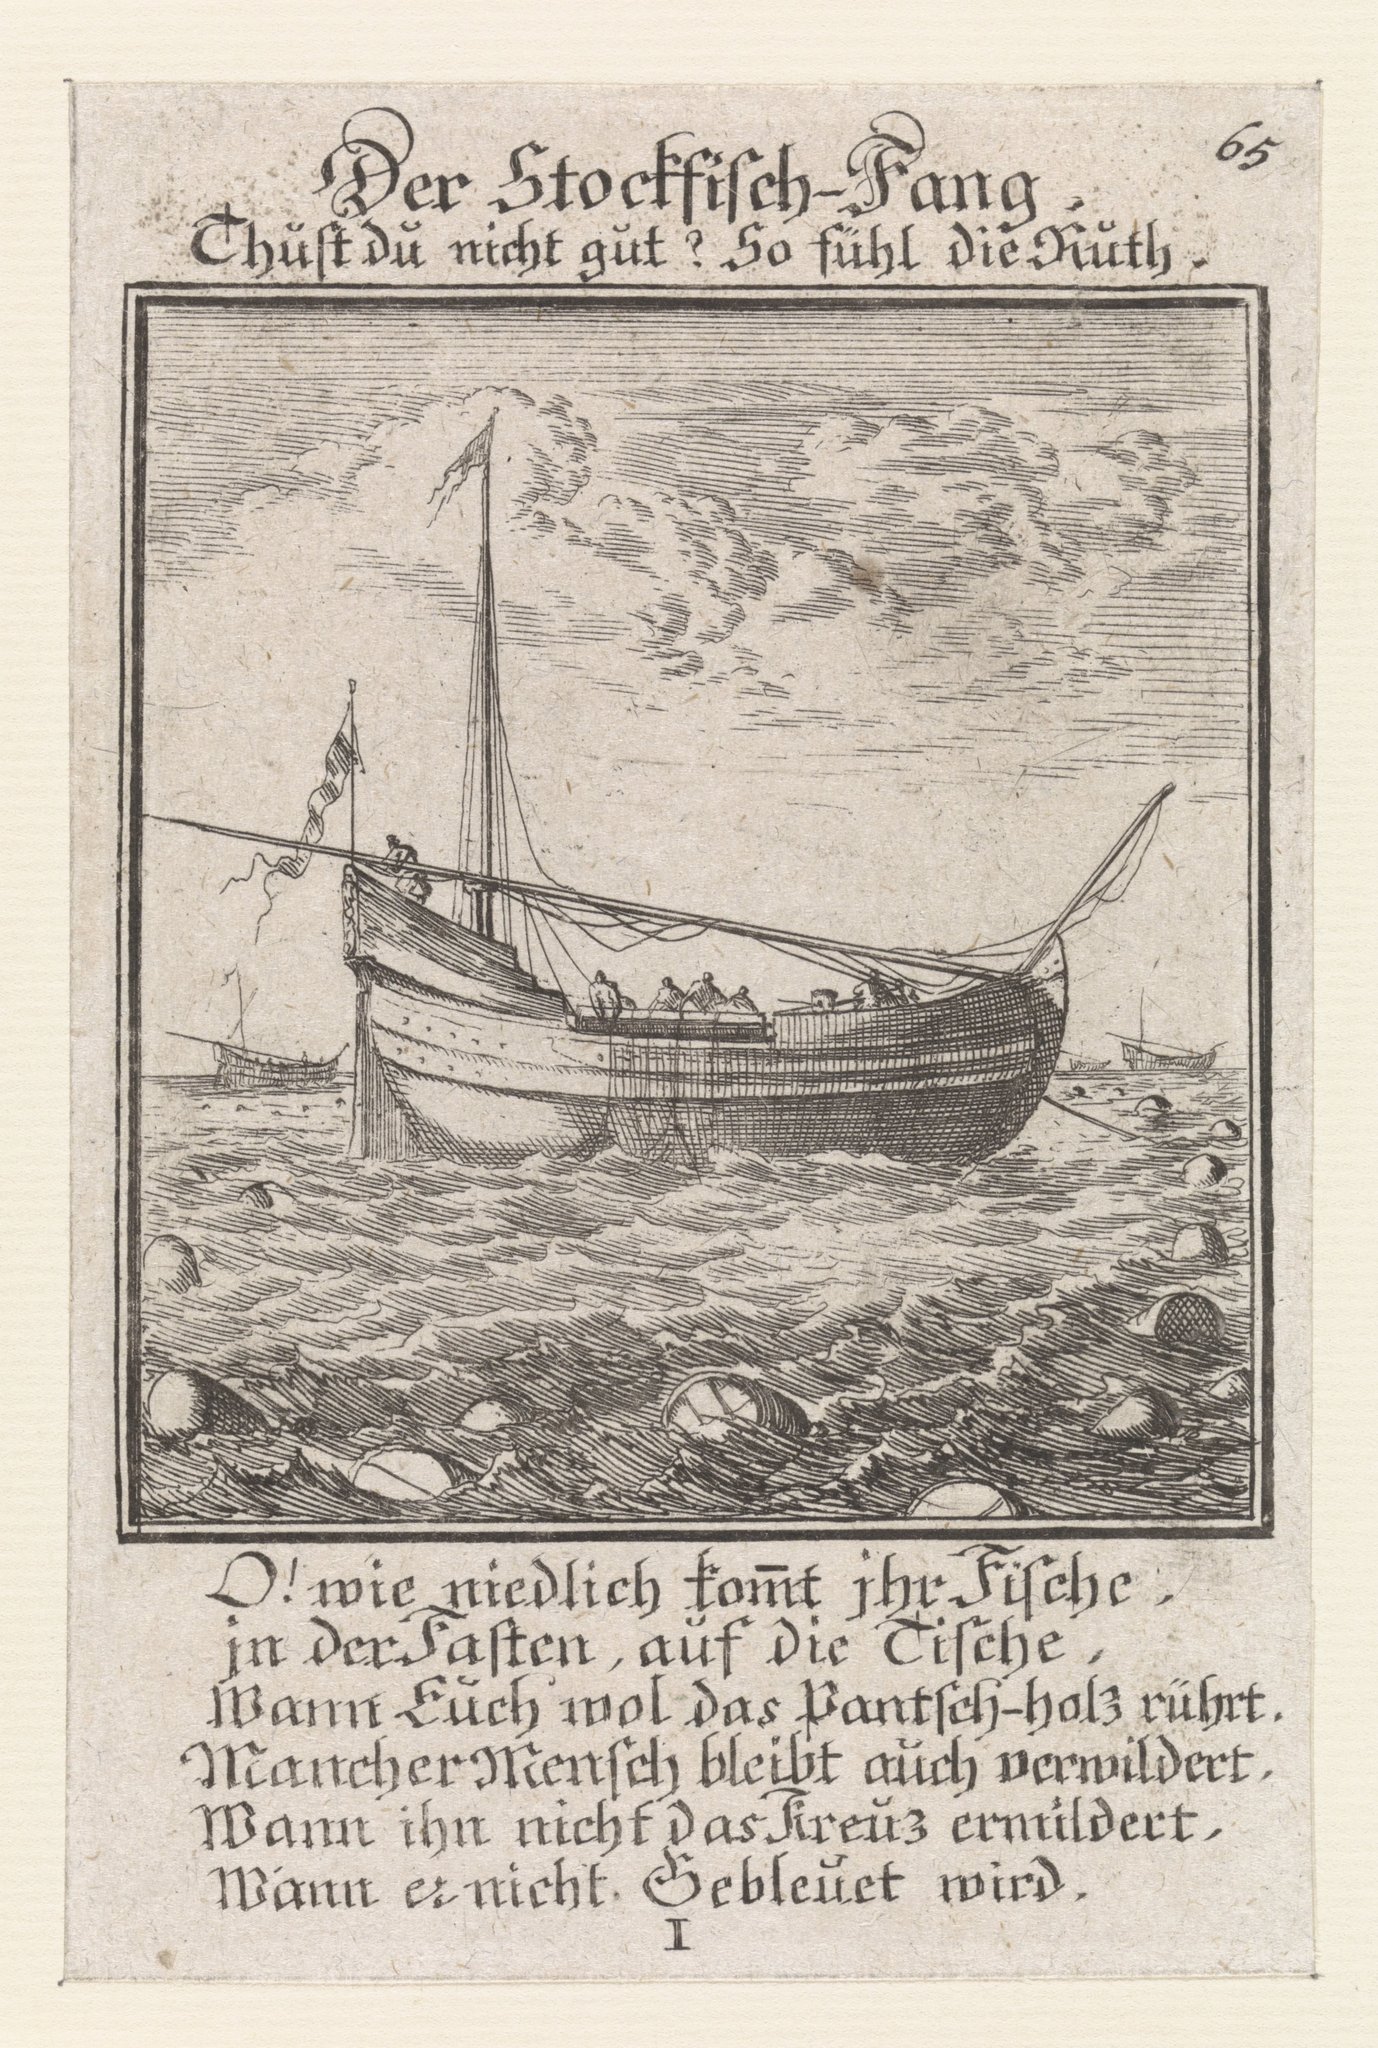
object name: book illustration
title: Der Stockfisch-Fang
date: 1711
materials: paper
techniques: etching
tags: sea and coastal fishery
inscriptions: collector's mark: Lugt 2228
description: Illustratie uit: Sancta Clara, Abraham à. Etwas für Alle, das ist: Eine kurtze Beschreibung allerley Stands- Ambts- und Gewerbs-Persohnen (...), 3 delen (1699-1733). Würtzburg: Martin Frank Hertz, 1711, dl. II, p. 647. Het betreft hier de tweede druk van deel II.